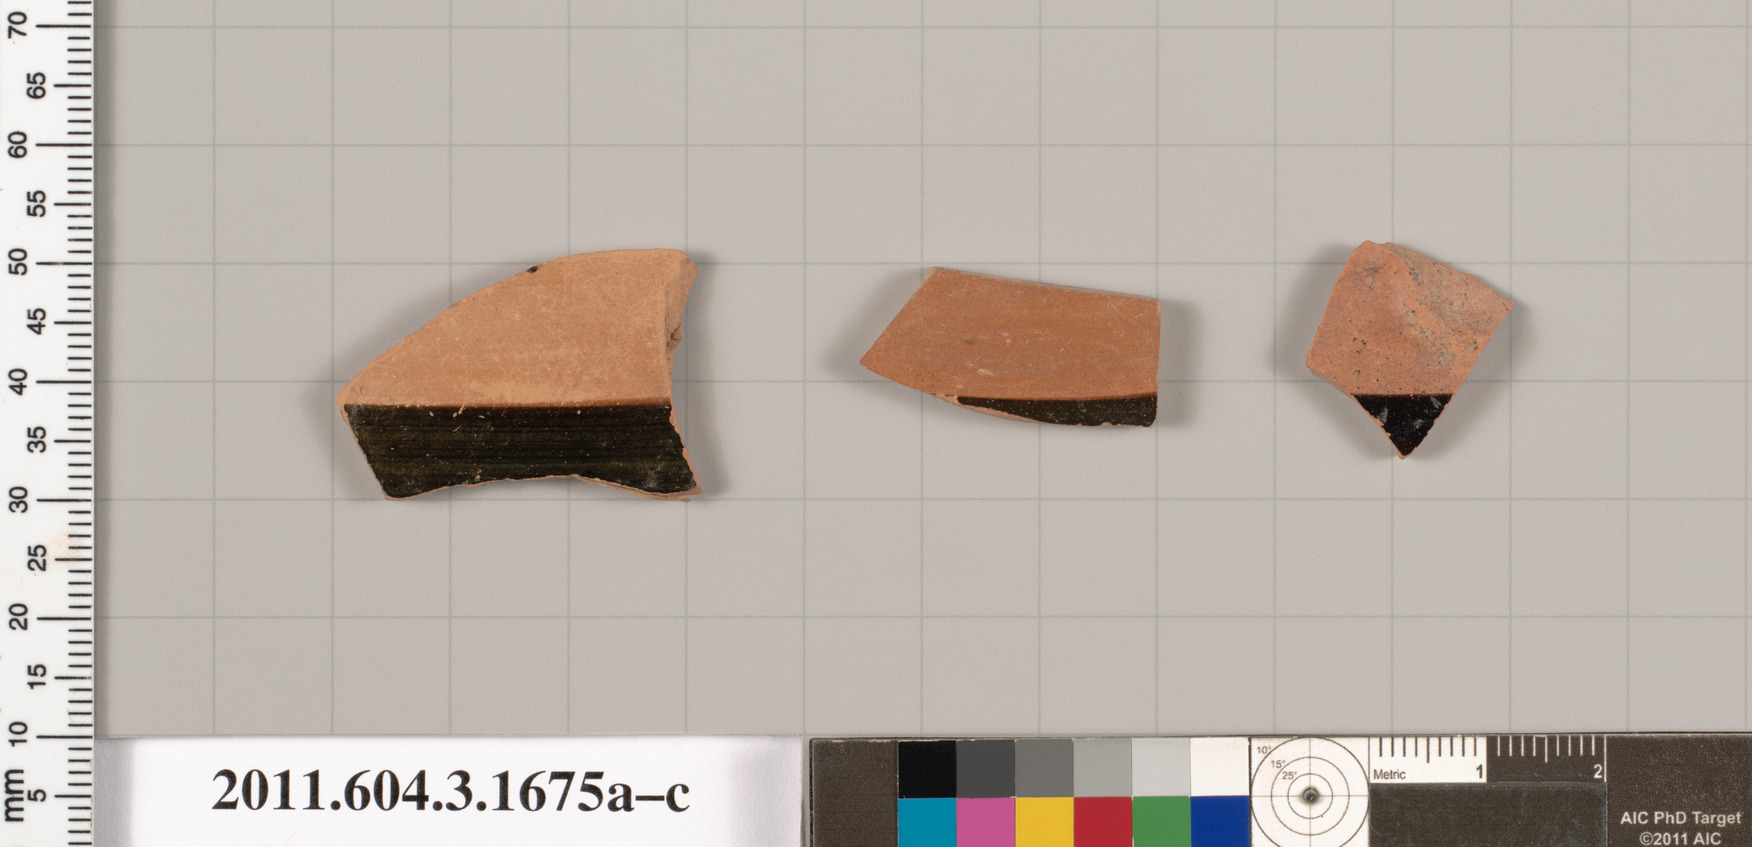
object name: kylix fragment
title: Terracotta fragments of kylikes: Band or lip cups (drinking cups)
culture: greek, attic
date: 550-526 BCE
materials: terracotta